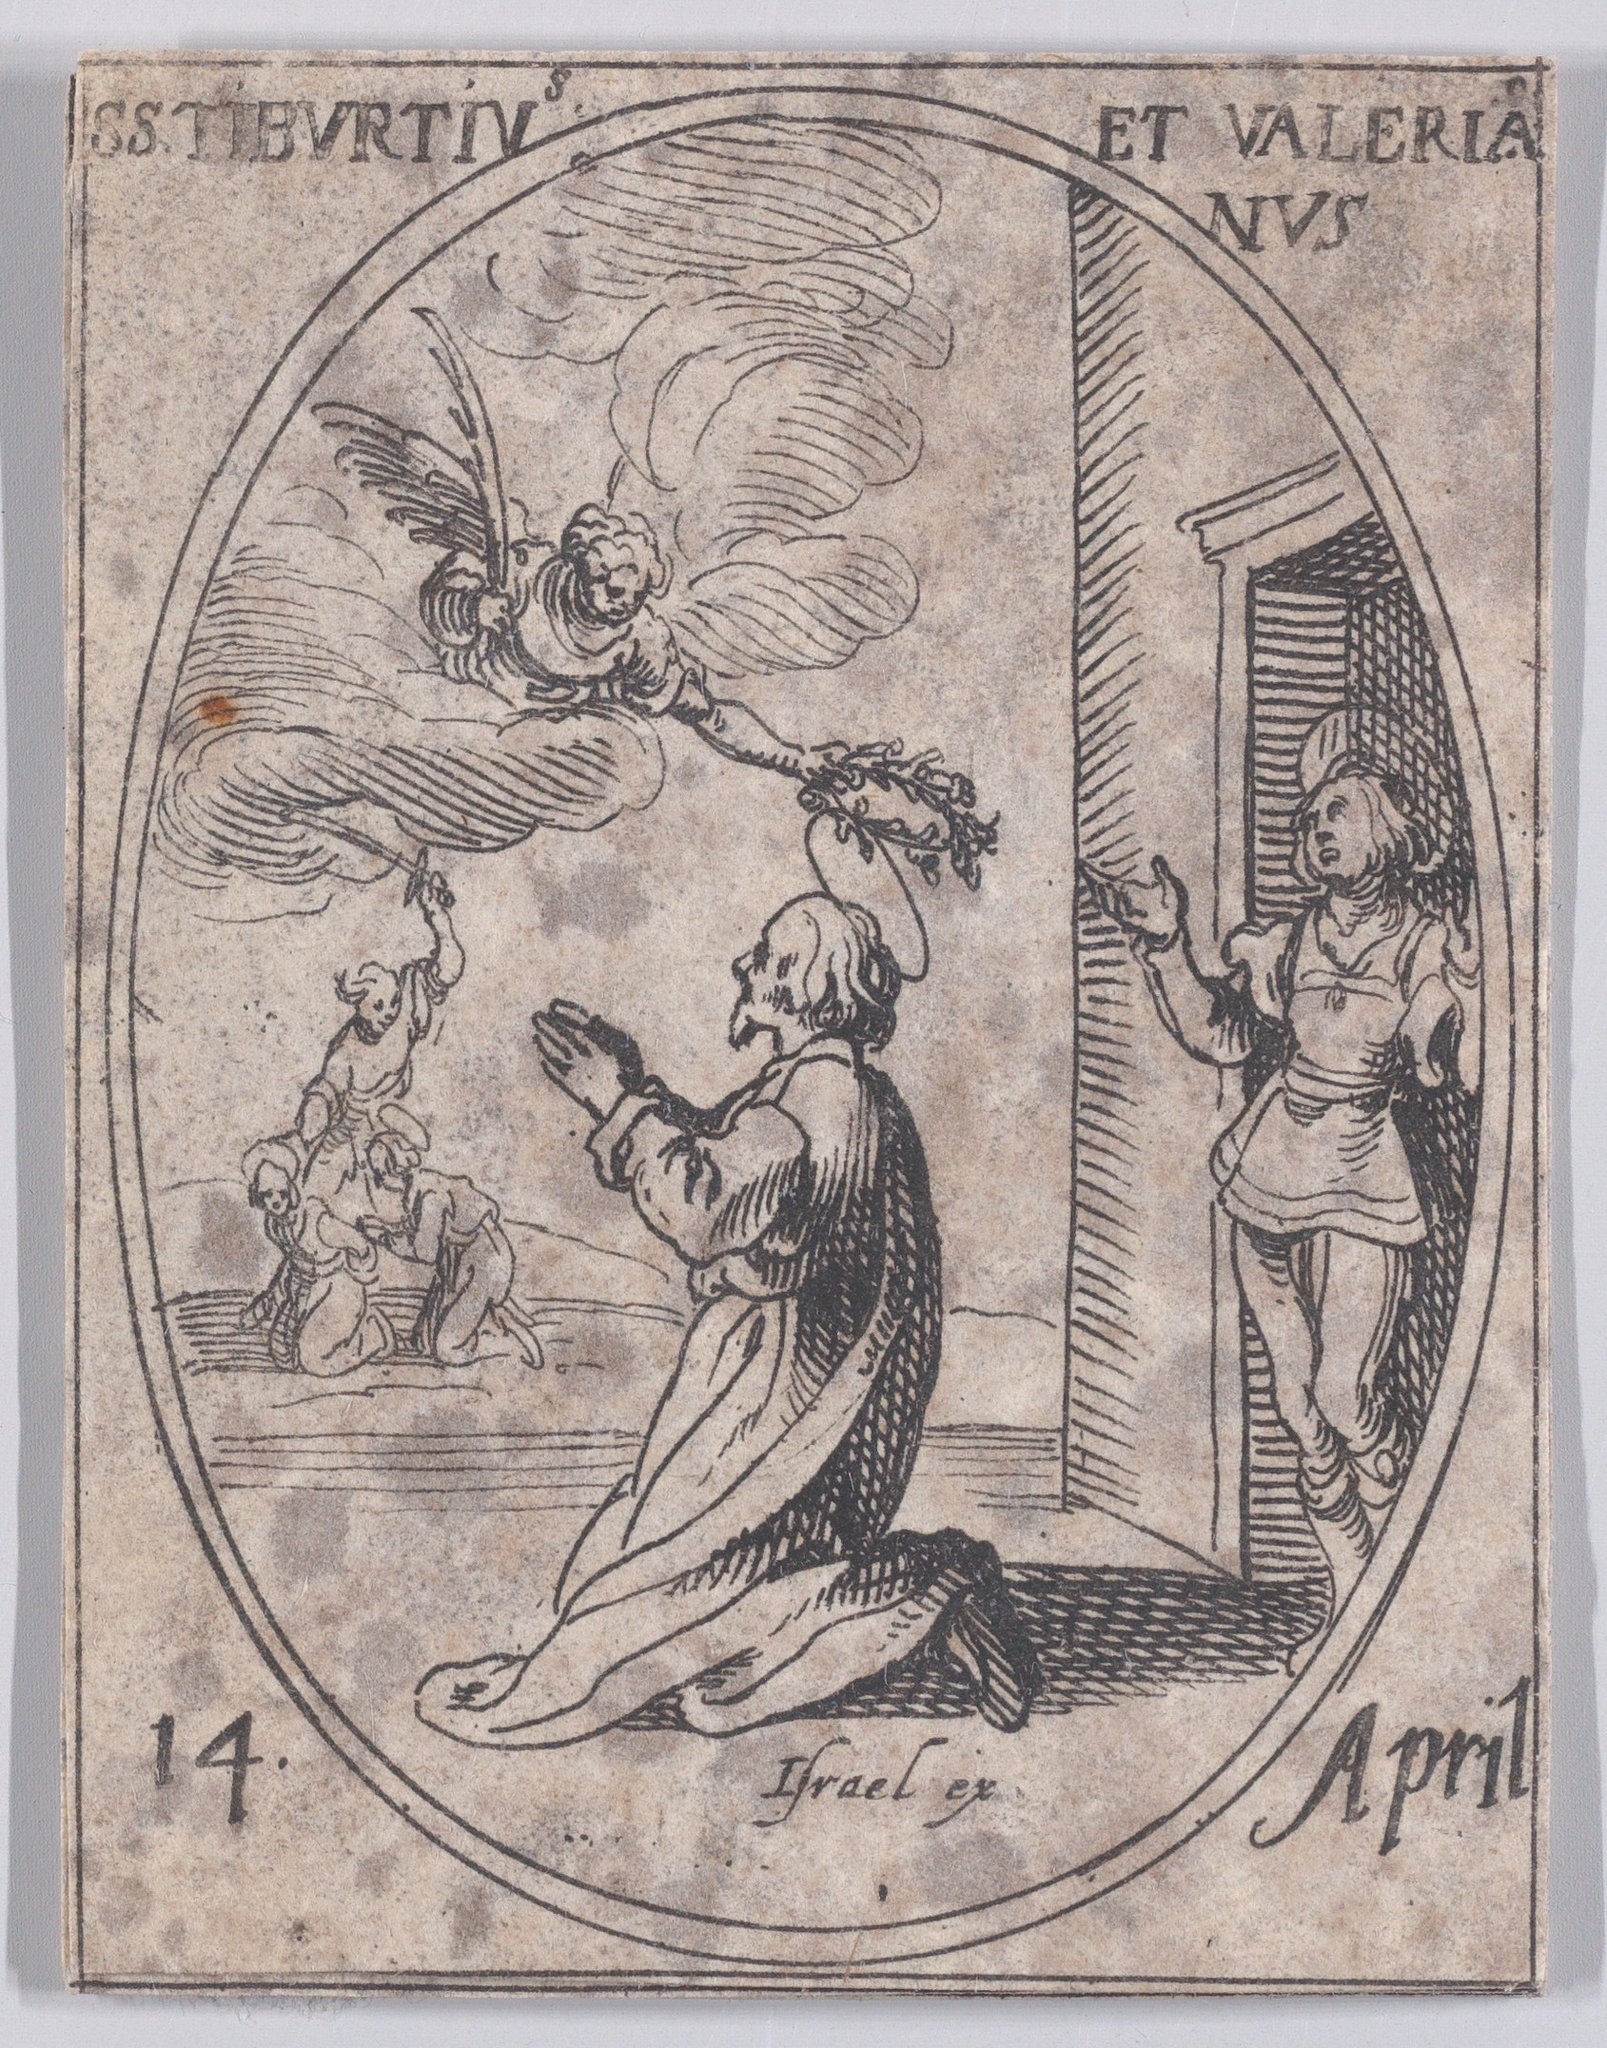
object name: print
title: S. Tiburce et S. Valérian (St. Tiburtius and St. Valerian), April 14th, from "Les Images De Tous Les Saincts et Saintes de L'Année" (Images of All of the Saints and Religious Events of the Year)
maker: jacques callot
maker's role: artist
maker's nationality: french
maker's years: 1592-1635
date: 1636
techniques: etching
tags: men,saints